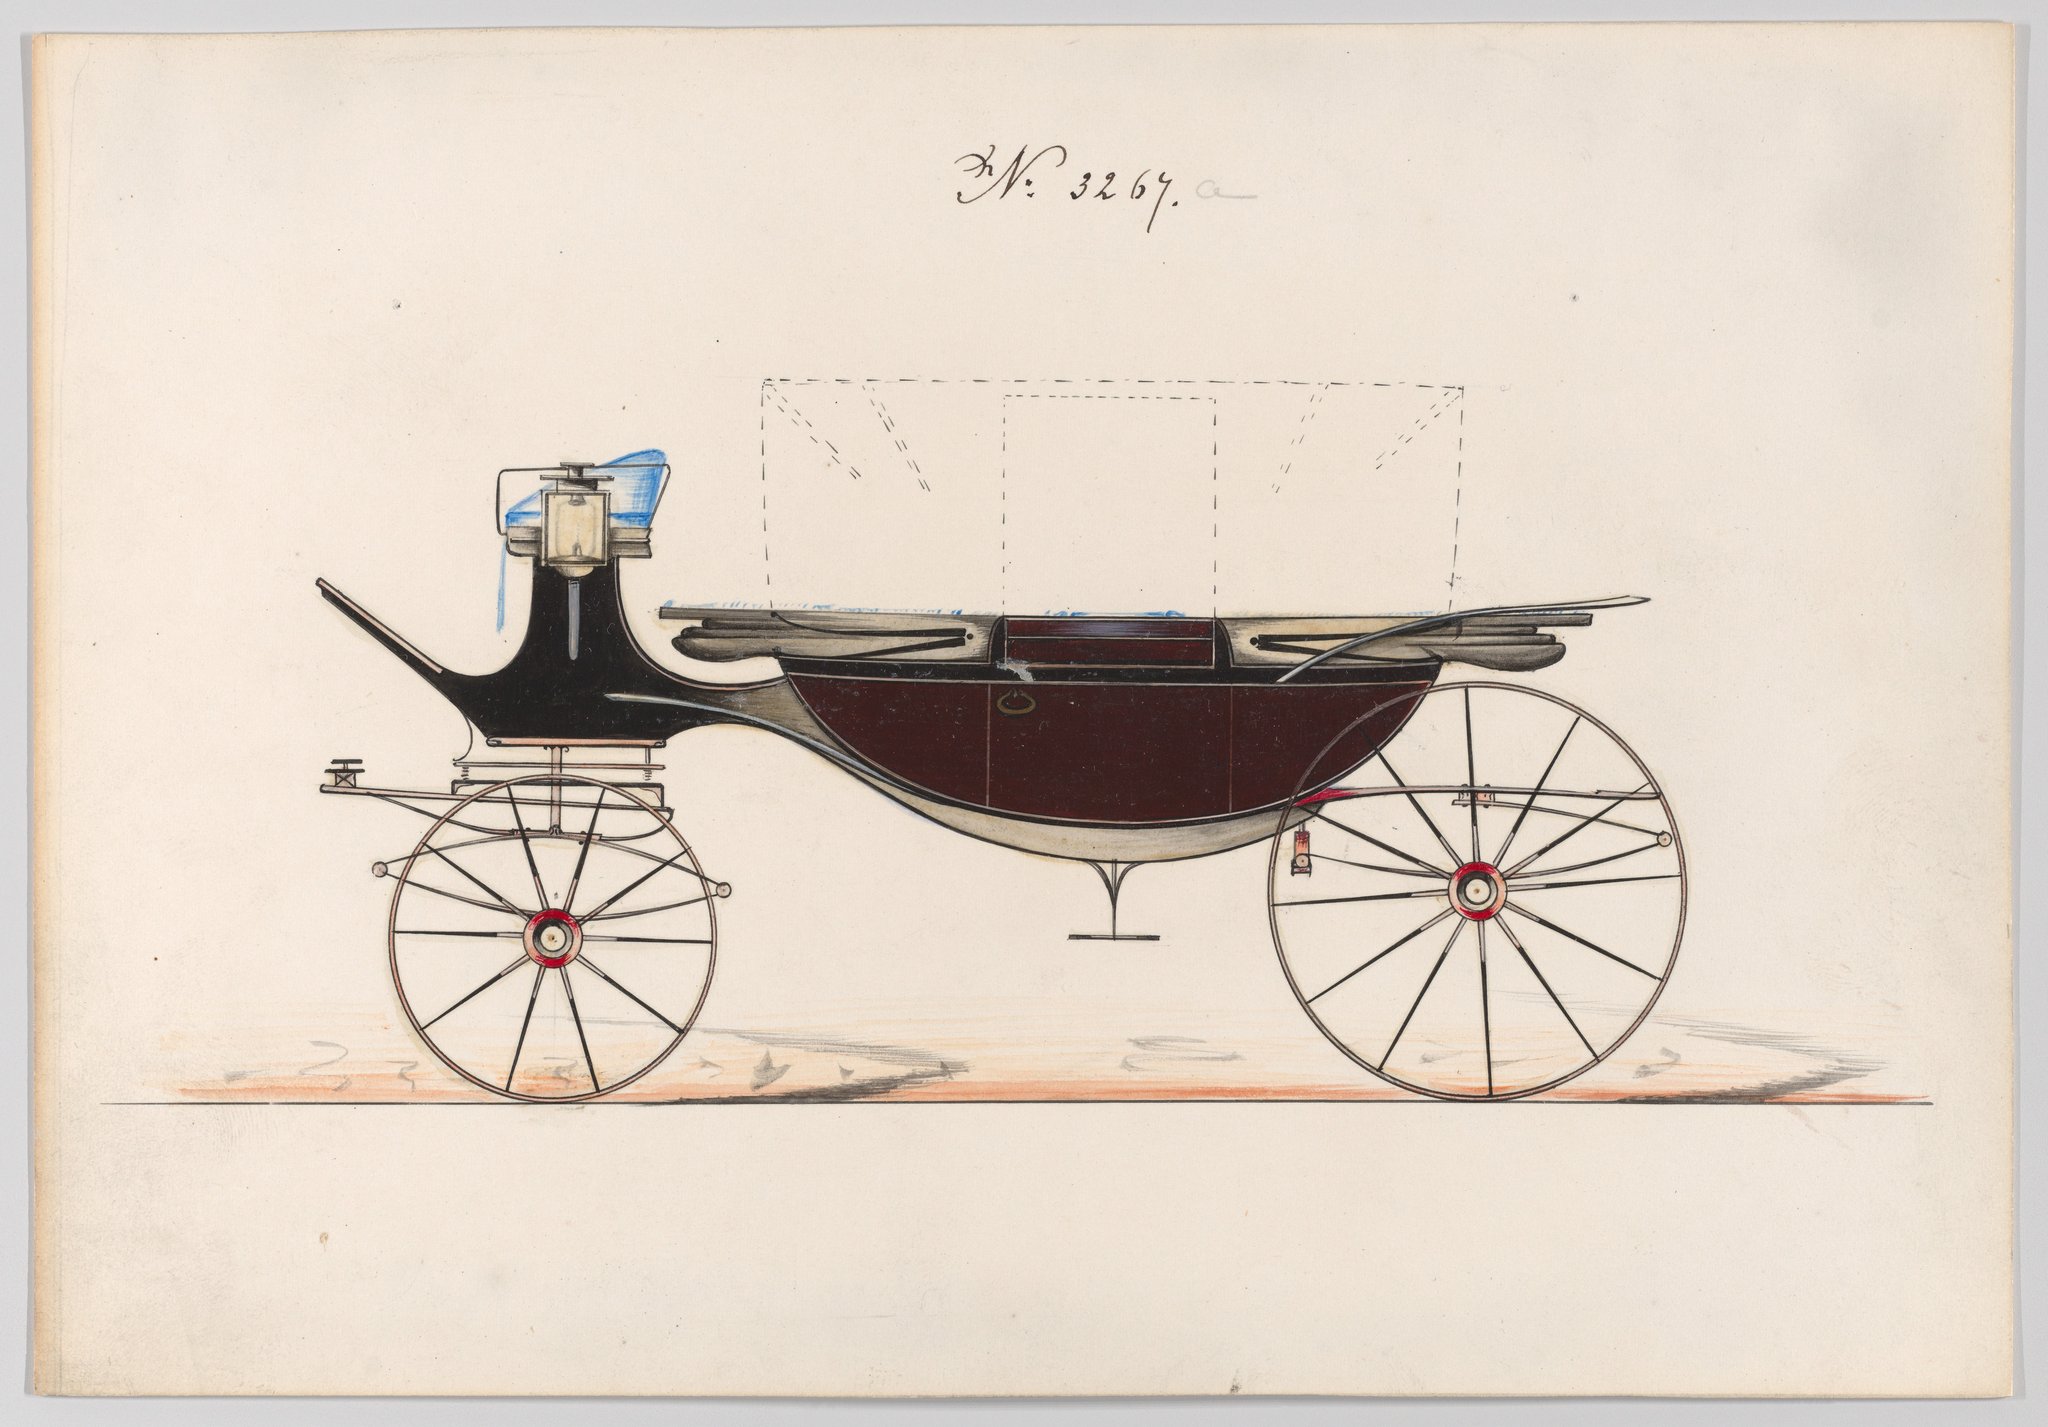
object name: drawing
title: Design for Landau, No. 3267a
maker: brewster & co.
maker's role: manufacturer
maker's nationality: american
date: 1876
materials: gouache, gum arabic, ink, watercolor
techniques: pen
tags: carriages